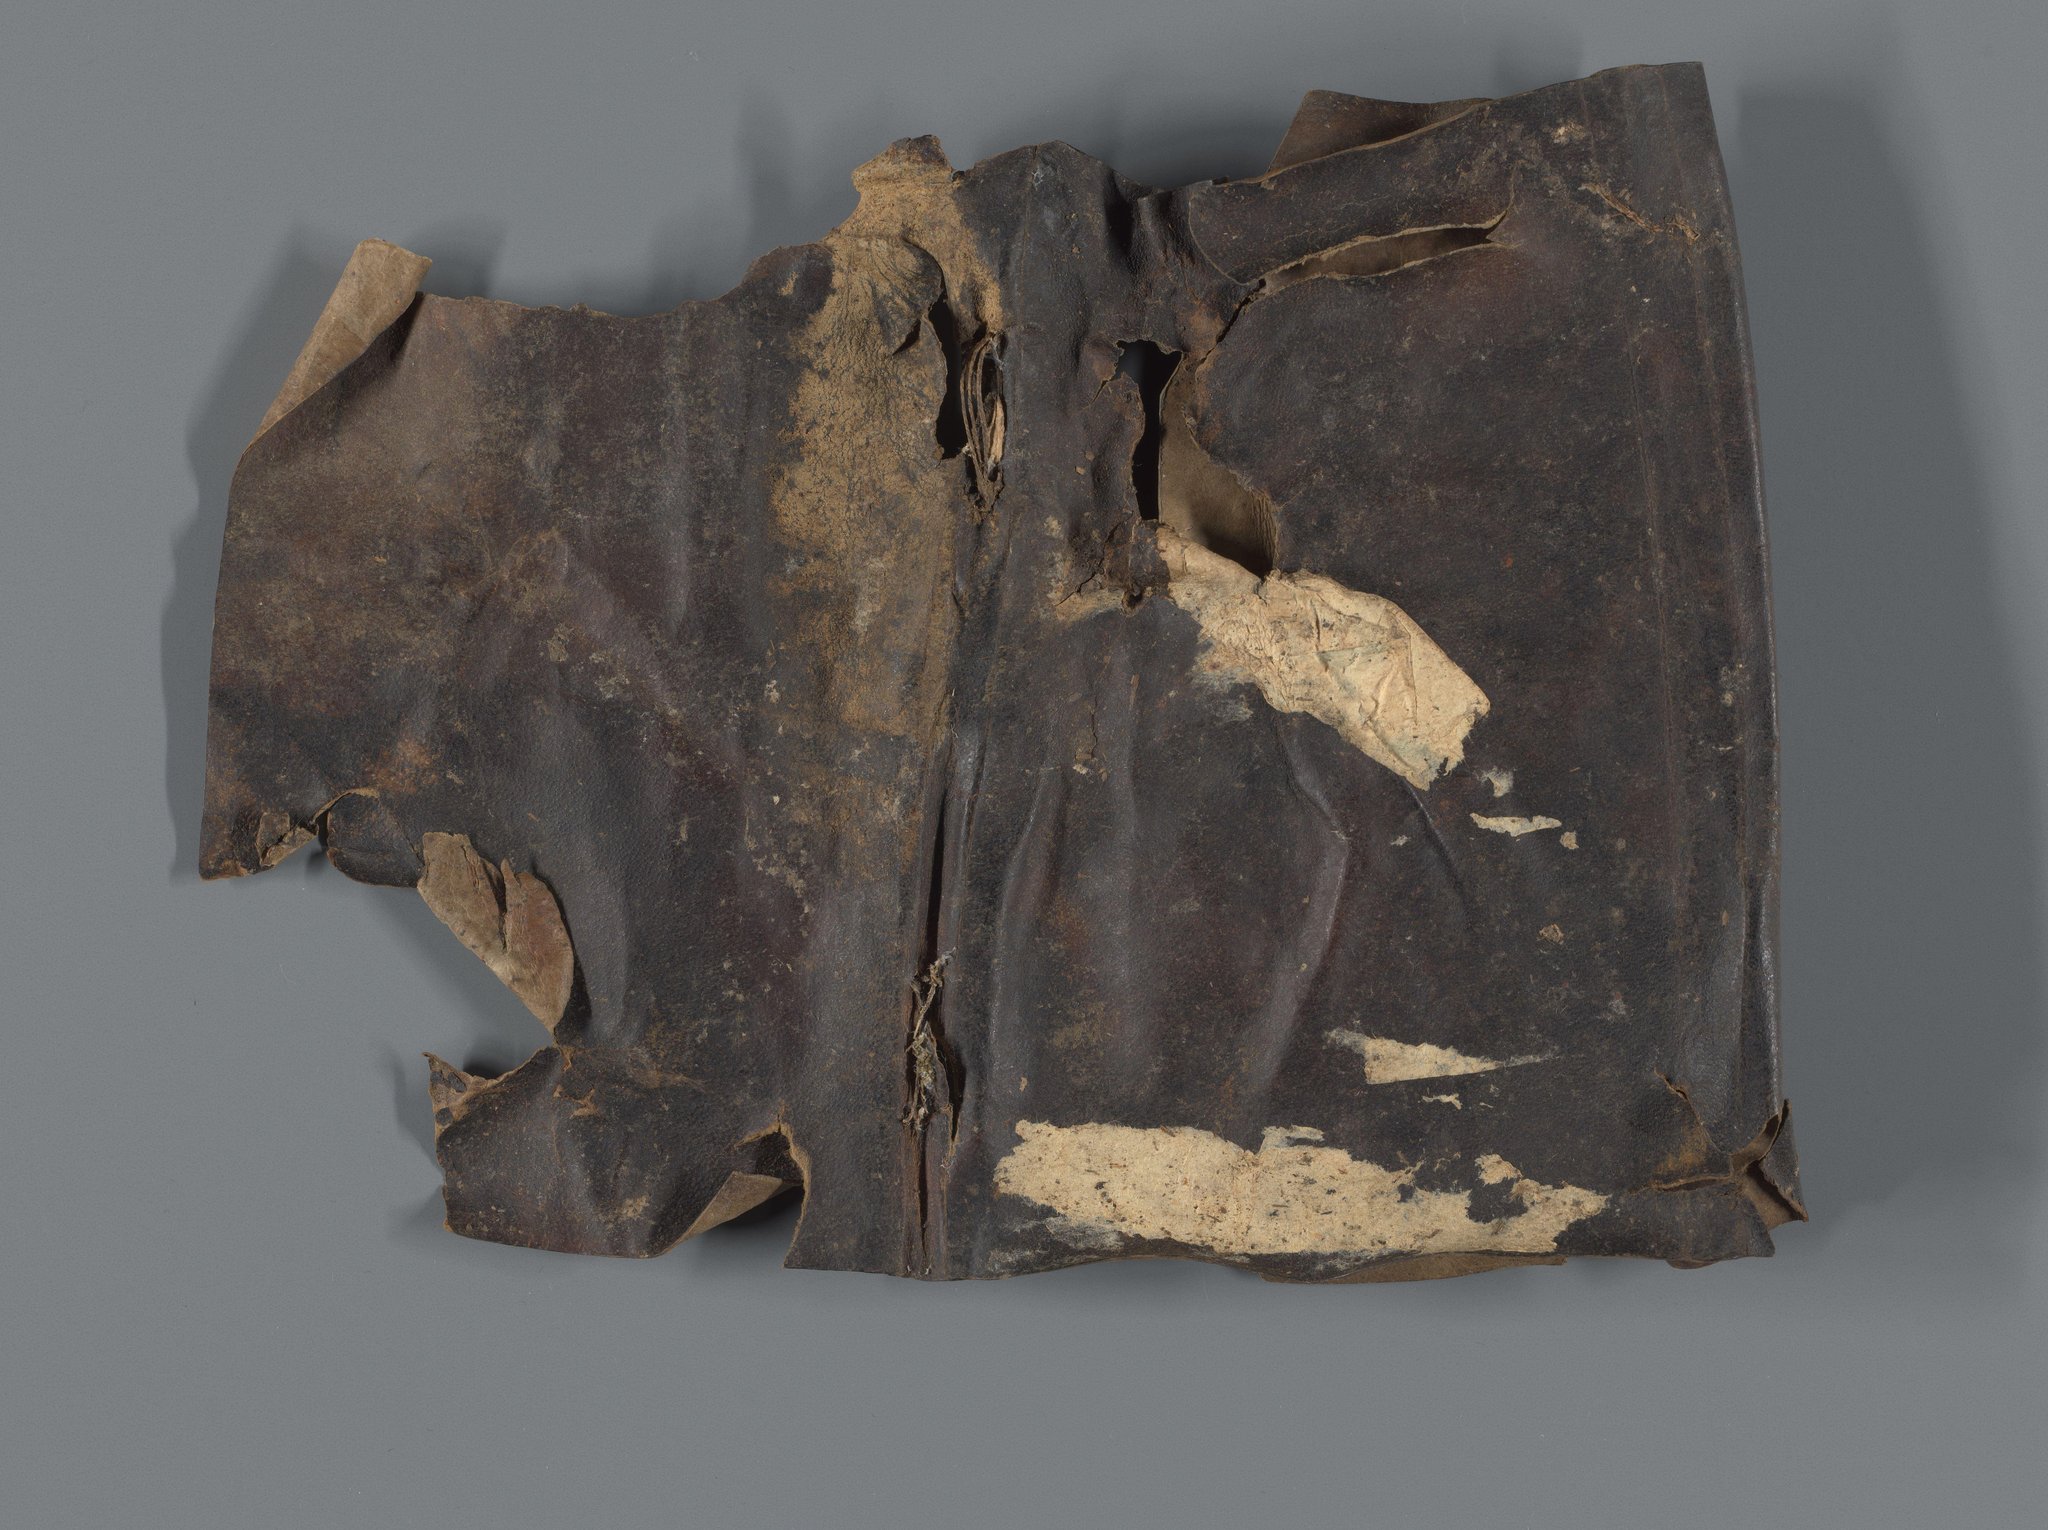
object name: book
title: Epistelen ende Evangelien van den geheelen Jare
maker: Anonymous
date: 1590-1596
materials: horn, paper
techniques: printing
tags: willem barendsz., amsterdam, jacob van heemskerck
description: Fragmenten van een Hollands godsdienstig boek, naar 't schijnt voorzien geweest van een kalender inhoudende stichtelijke lectuur uit de bijbel. Volgens De Jonge in hoornen band. Volgens foto's F1885-8 en F1886-9/10/11 zou NM-7808 hierbij horen. Dit kan echter niet kloppen. Door AvdP in nov. 1994 (weer) toegevoegd een ongenummerde kaft zie foto 6521 en 6522.